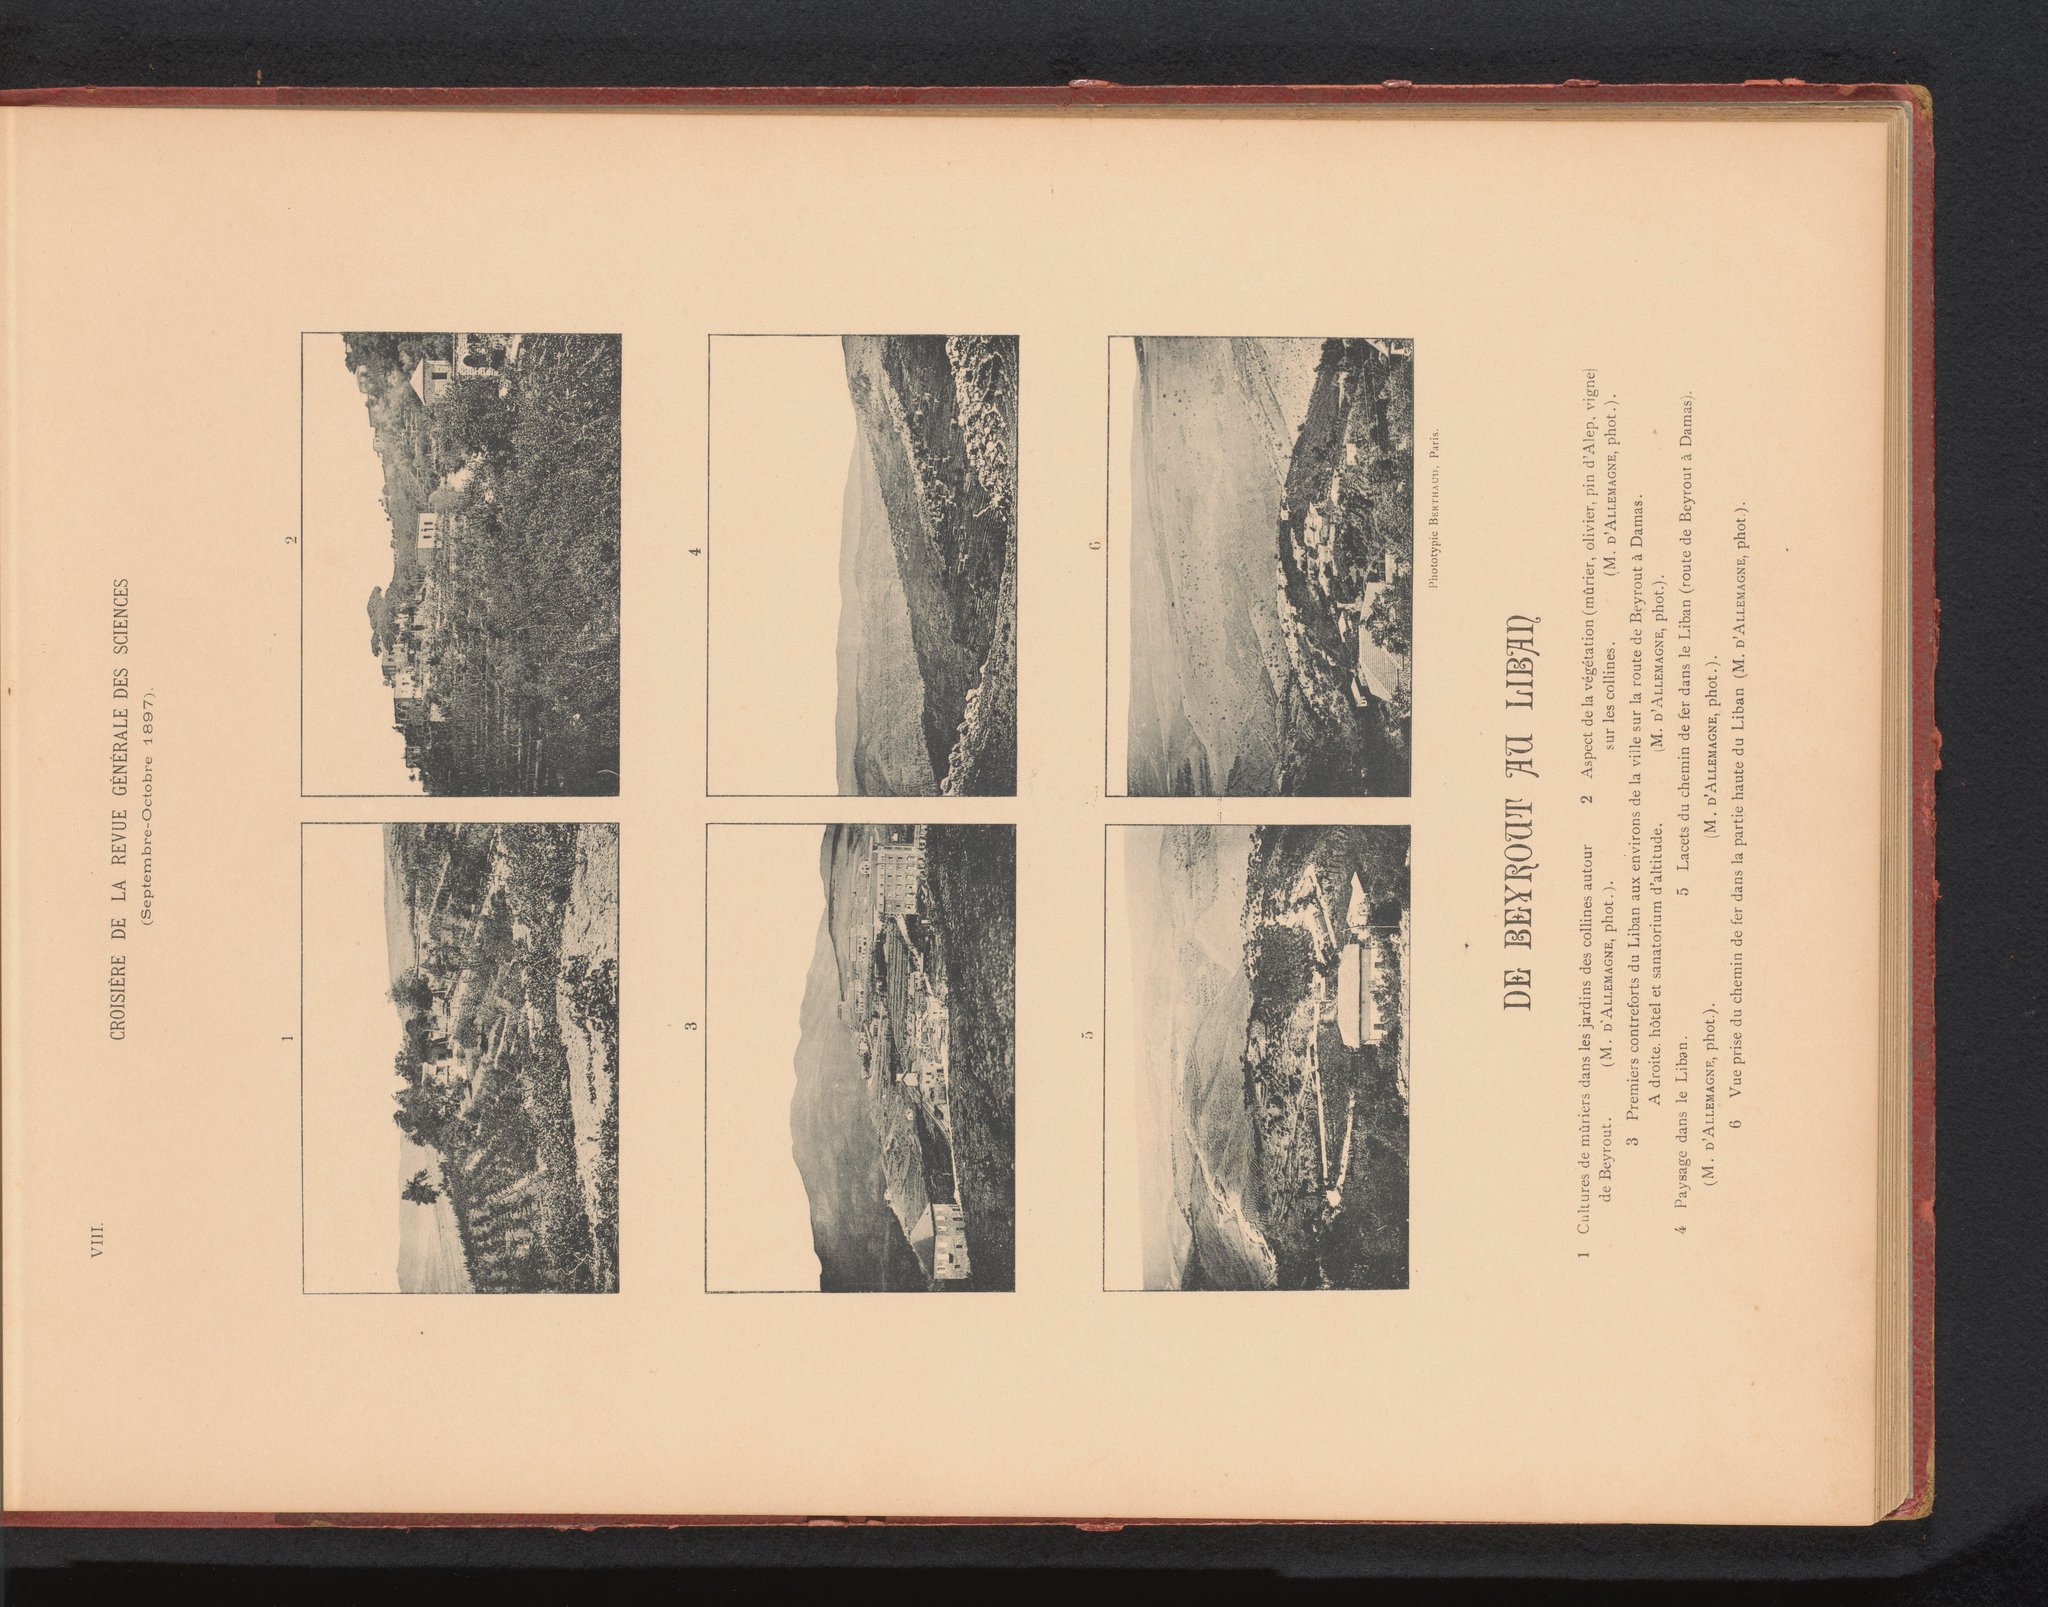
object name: page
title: Zes gezichten op Beiroet, Libanon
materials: paper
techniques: photograph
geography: paris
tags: low hill country, prospect of city, town panorama, silhouette of city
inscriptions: number: ‘VIII.’, inscription: ‘1 Cultures de mûriers dans les jardins des collines autour/ de Beyrout. (M. d'Allemagne, phot.)./ 2 Aspect de la végétation (mûrier, olivier, pin d'Alep, bigne)/ sur les collines. (M. d'Allemagne, phot.)./ 3 Premiers contreforts du Liban aux environs de la ville sur la route de Beyrout à Damas./ A droite, hôtel et sanatorium d'altitude. (M. d'Allemagne, phot.)./ 4 Paysage dans le Liban./ (M. d'Allemagne, phot.)./ 5 Lacets du chemin de fer dans le Liban (route de Beyrout à Damas)./ (M. d'Allemagne, phot.)./ 6 Vue prise de chemin de fer dans la partie haute du Liban (M. d'Allemagne, phot.).’